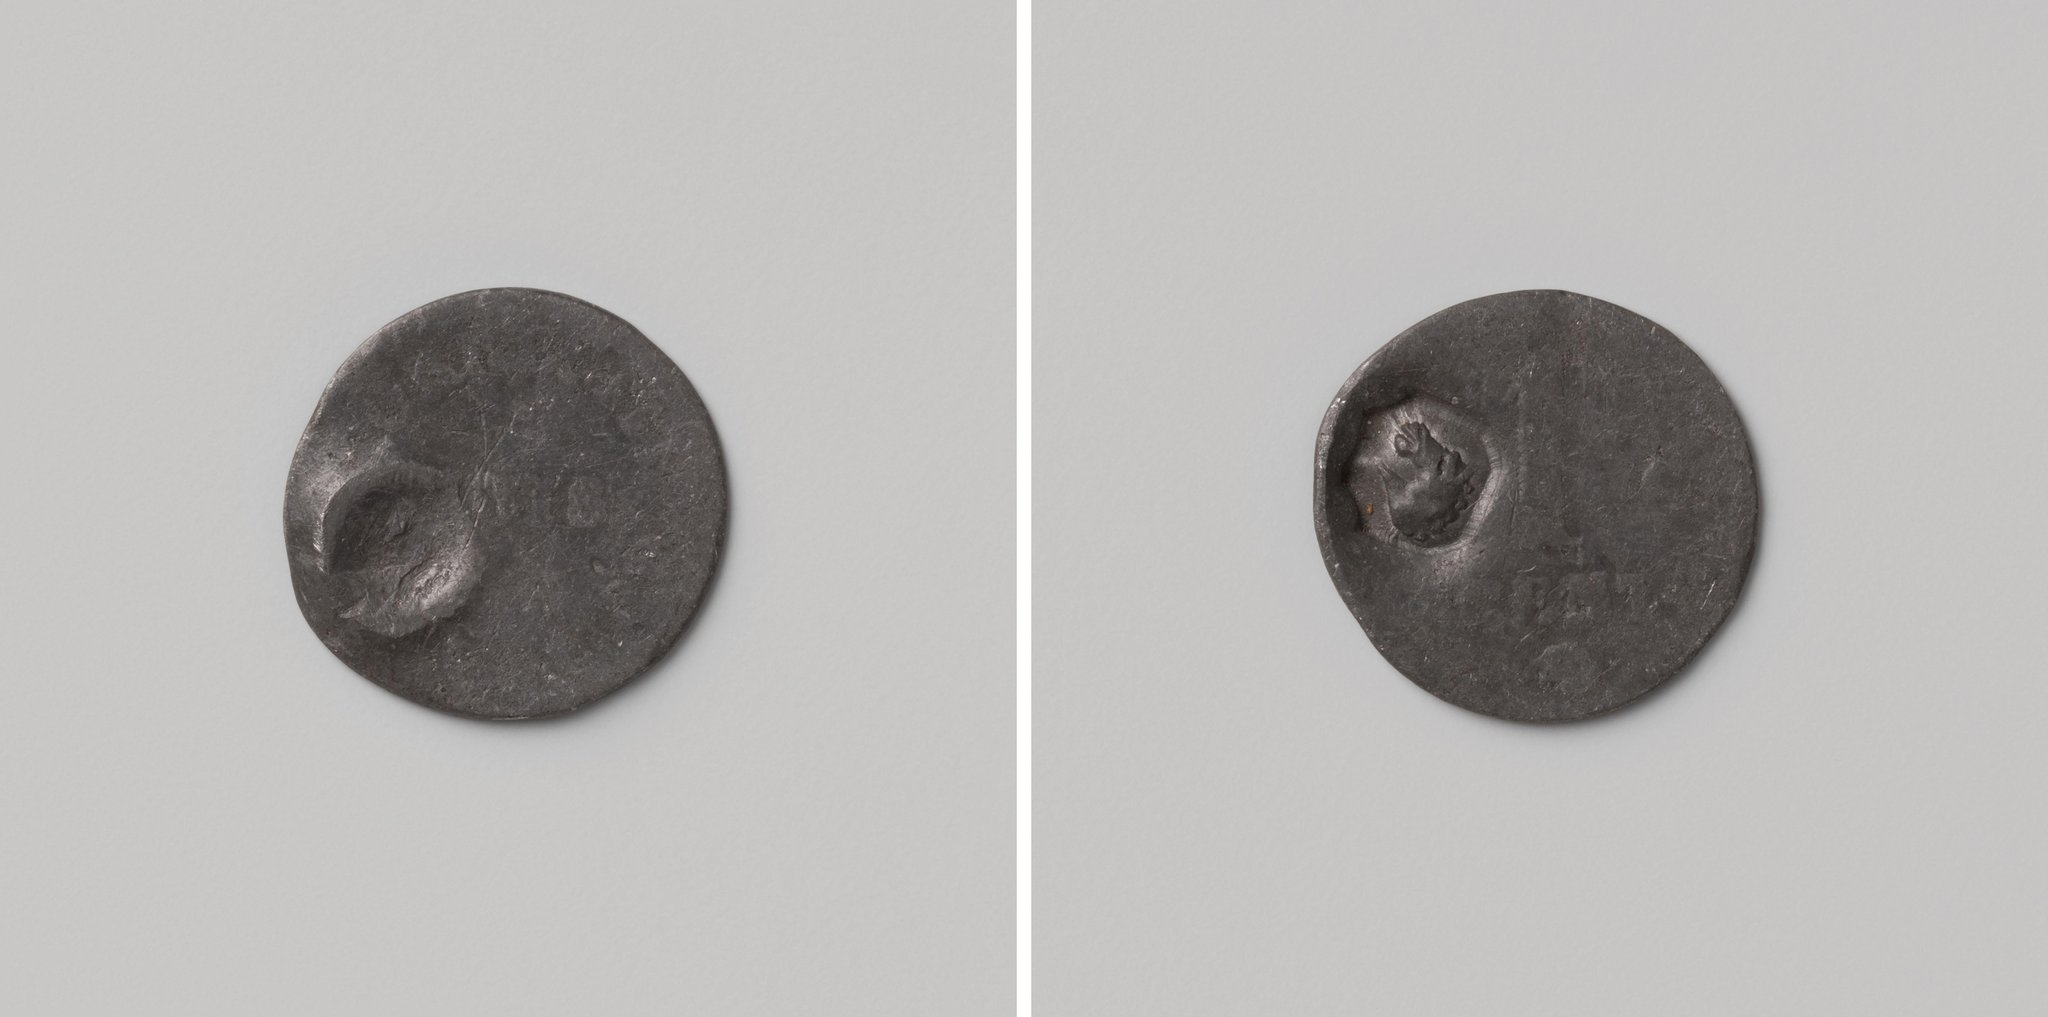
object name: huismunt prison money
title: Correctiehuis Sint Bernhard te Hemiksem, huismunt ter waarde van een cent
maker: joseph pierre braemt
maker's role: print maker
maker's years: 1796-1864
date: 1826-1833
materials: zinc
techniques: striking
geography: brussels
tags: ghent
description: Zinken betaalpenning. Voorzijde: opschrift binnen omschrift. Keerzijde: waardeaanduiding; links klop: paardekop